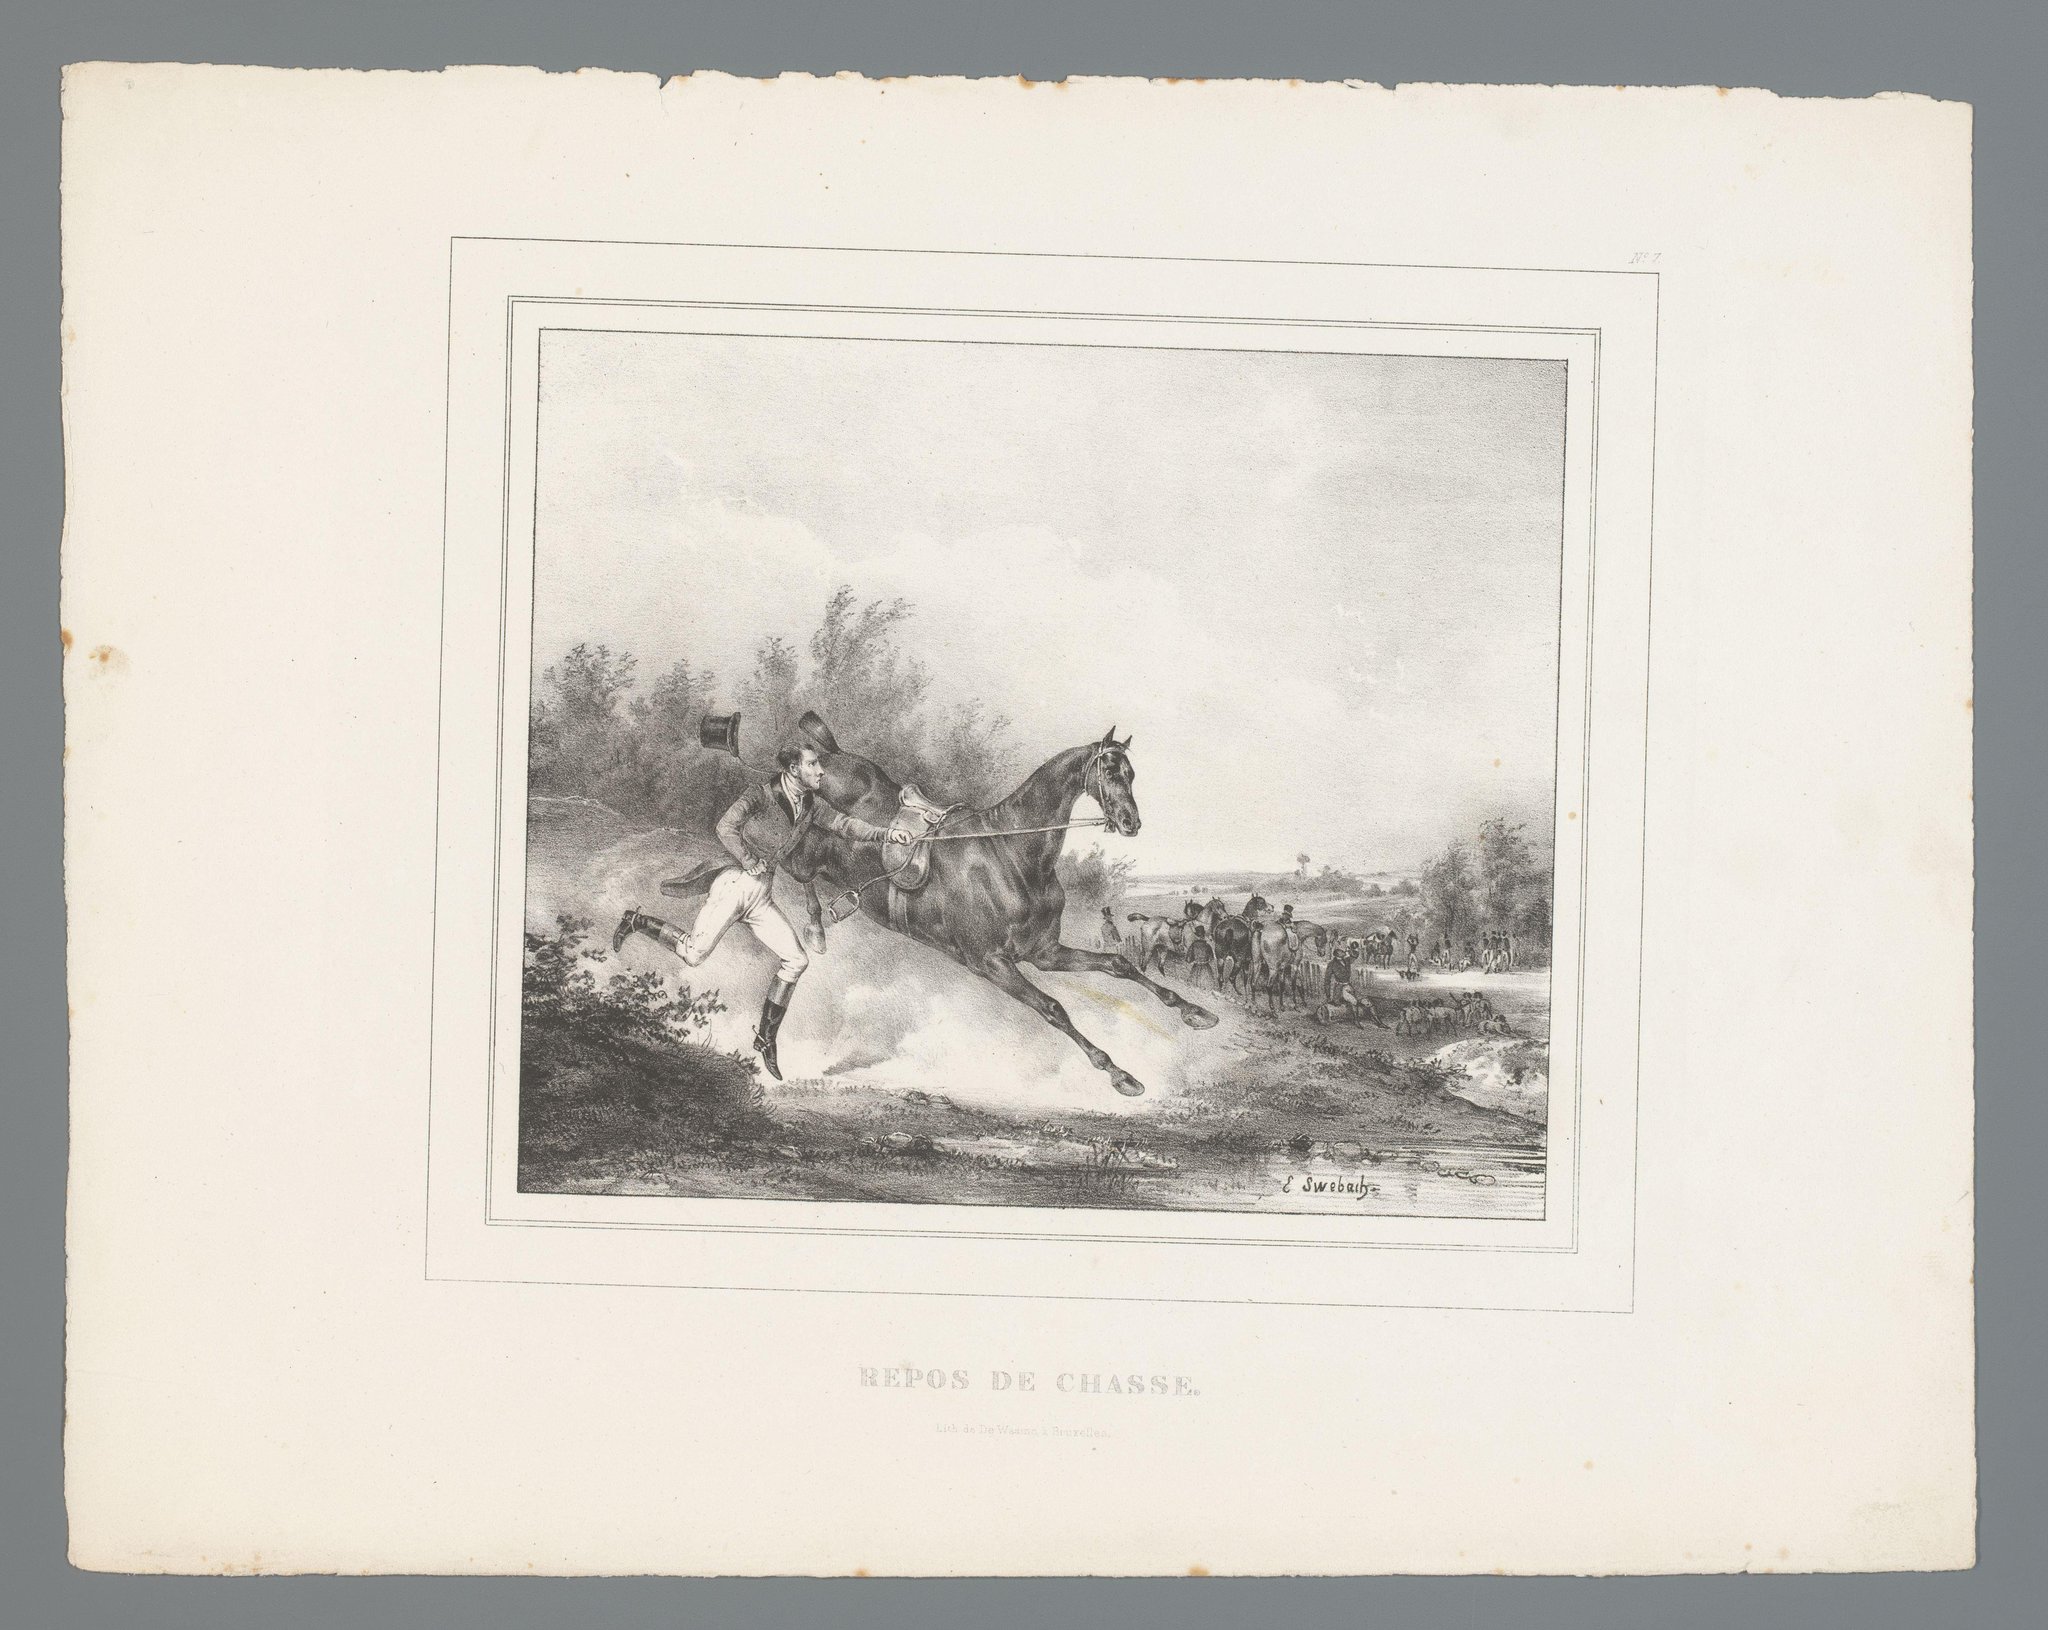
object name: print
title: Ongemakken van de drijfjacht met paarden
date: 1825-1827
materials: paper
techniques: lithograph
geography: brussels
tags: hunting, chase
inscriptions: collector's mark: Lugt 2228